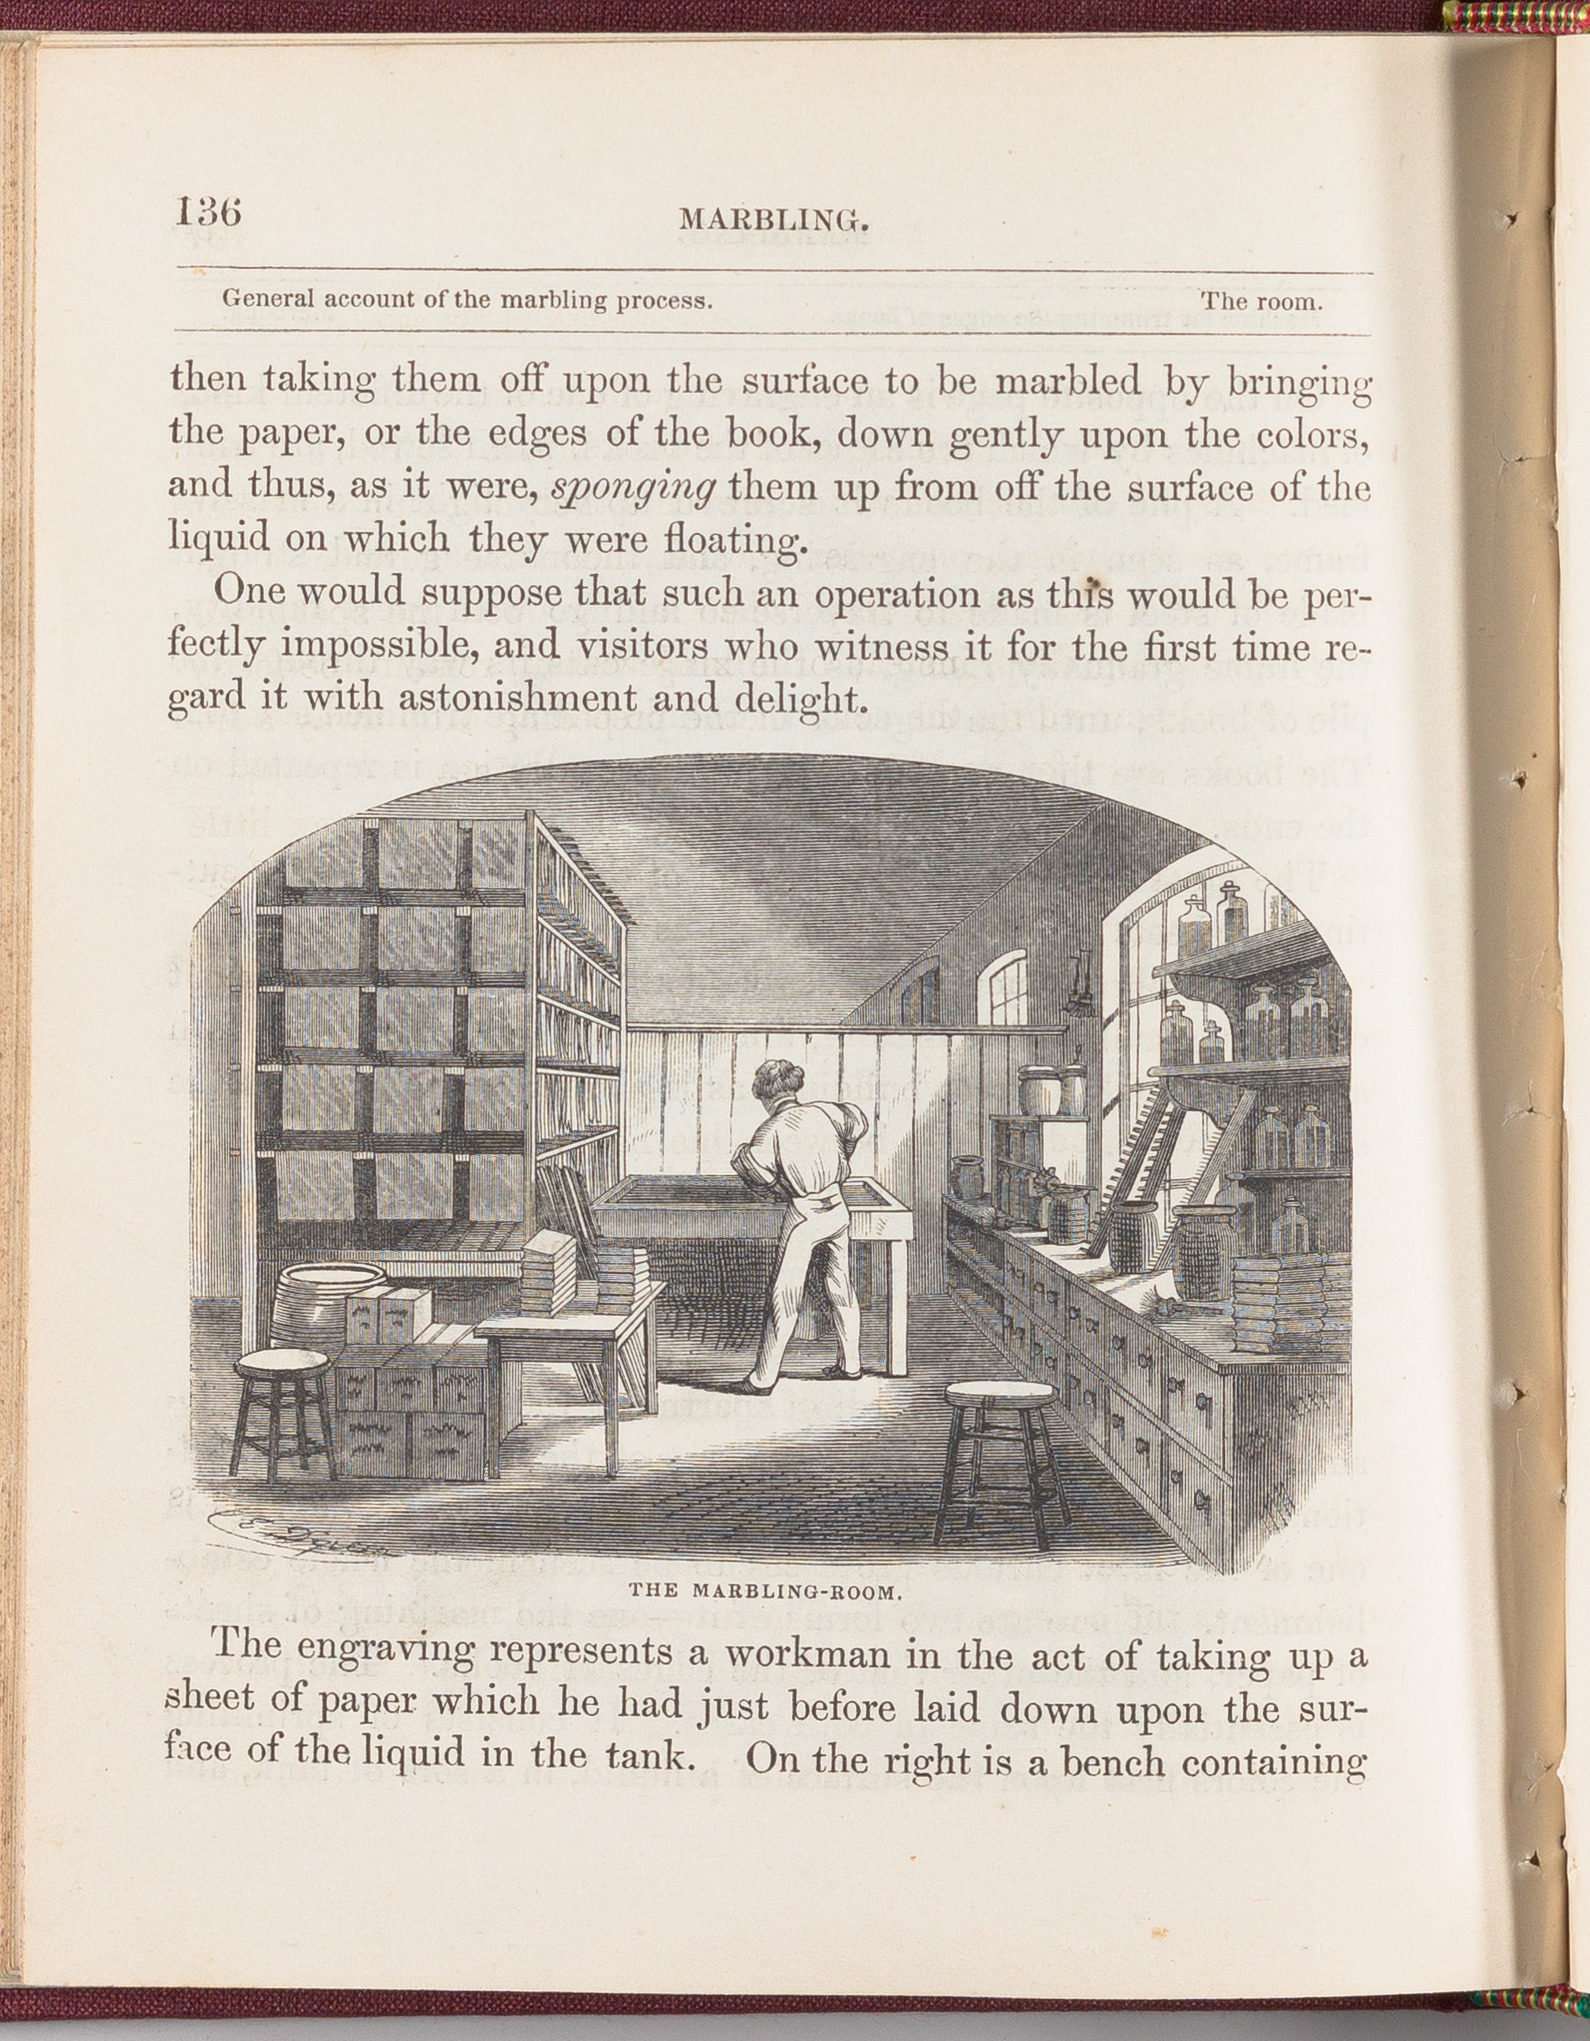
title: The Harper establishment; or, How the story books are made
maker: jacob abbott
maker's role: author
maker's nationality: american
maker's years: 1803-1879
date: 1855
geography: united states